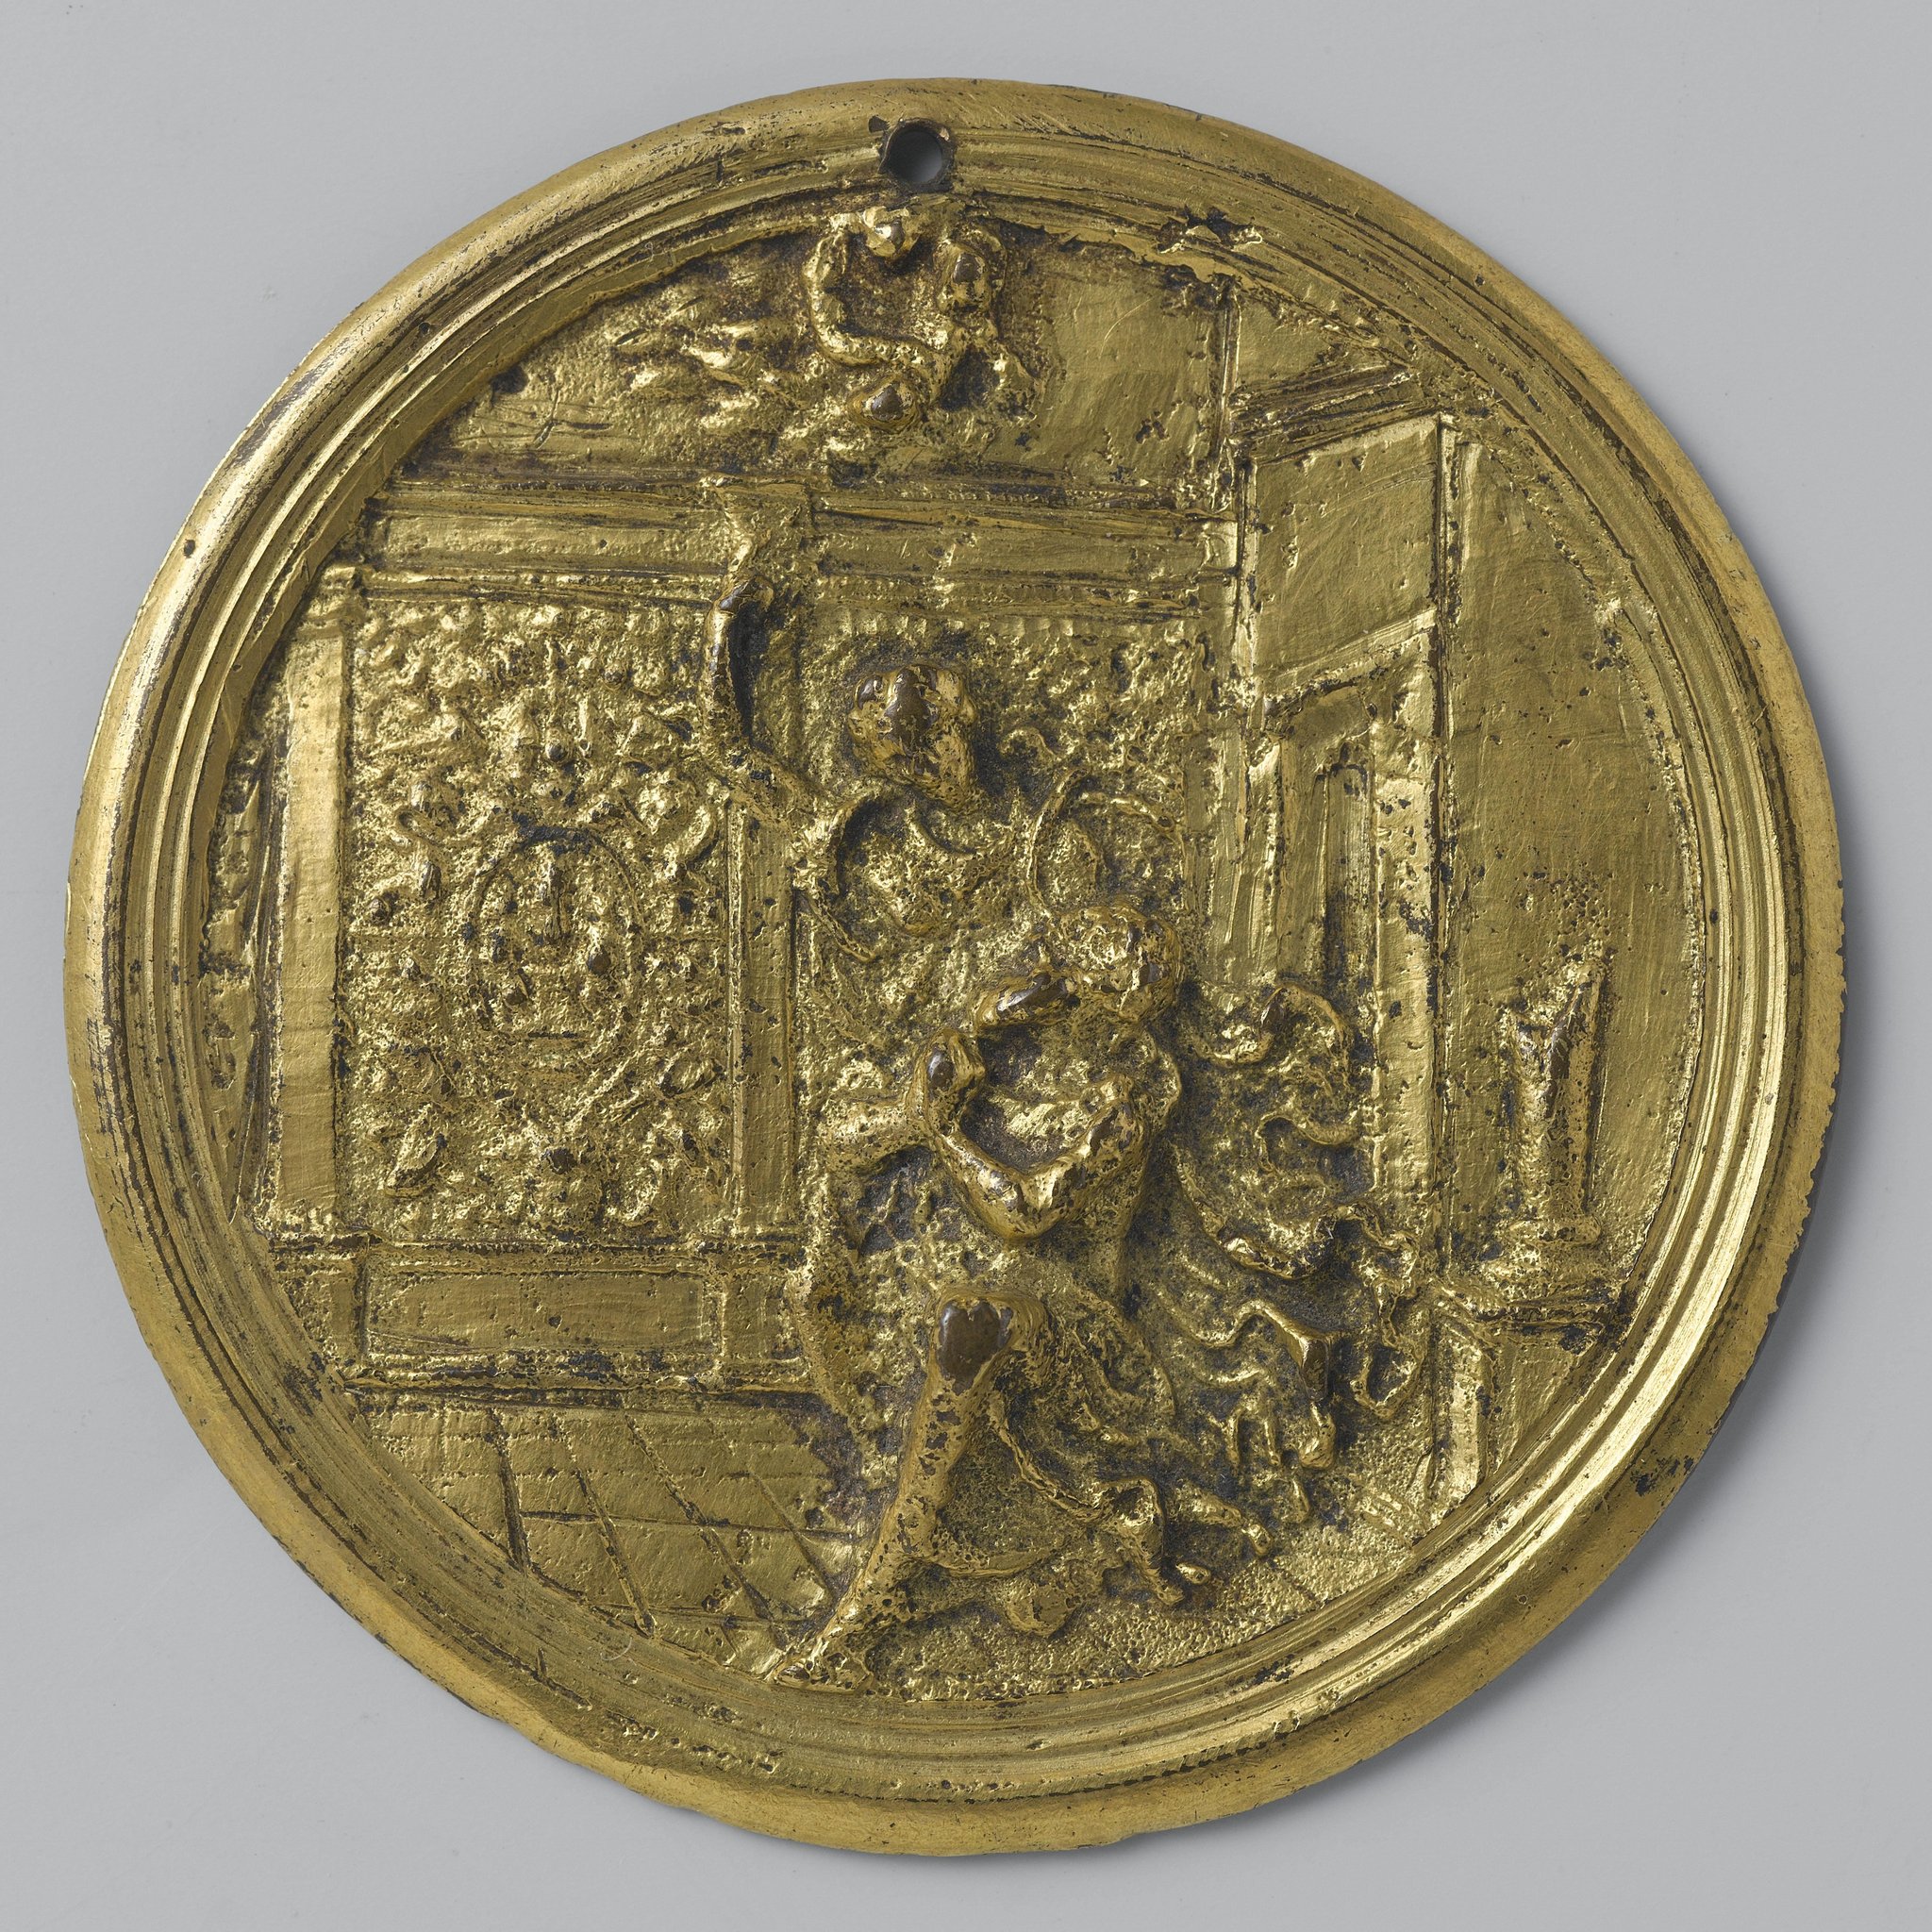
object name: sculpture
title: Augustus en de sibylle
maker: moderno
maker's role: jeweler, sculptor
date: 1475-1499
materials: bronze